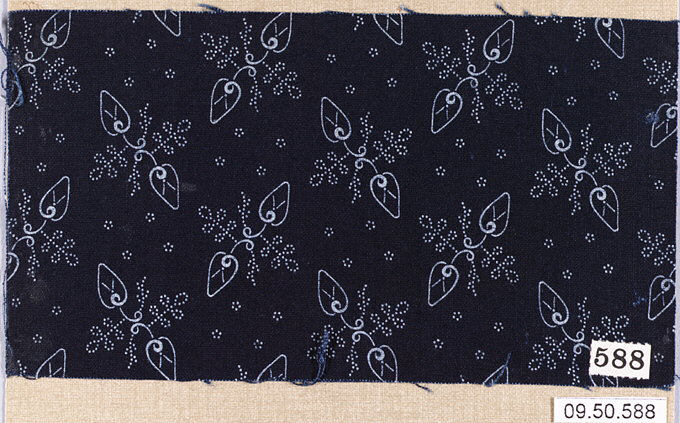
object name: piece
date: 1801-1900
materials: cotton